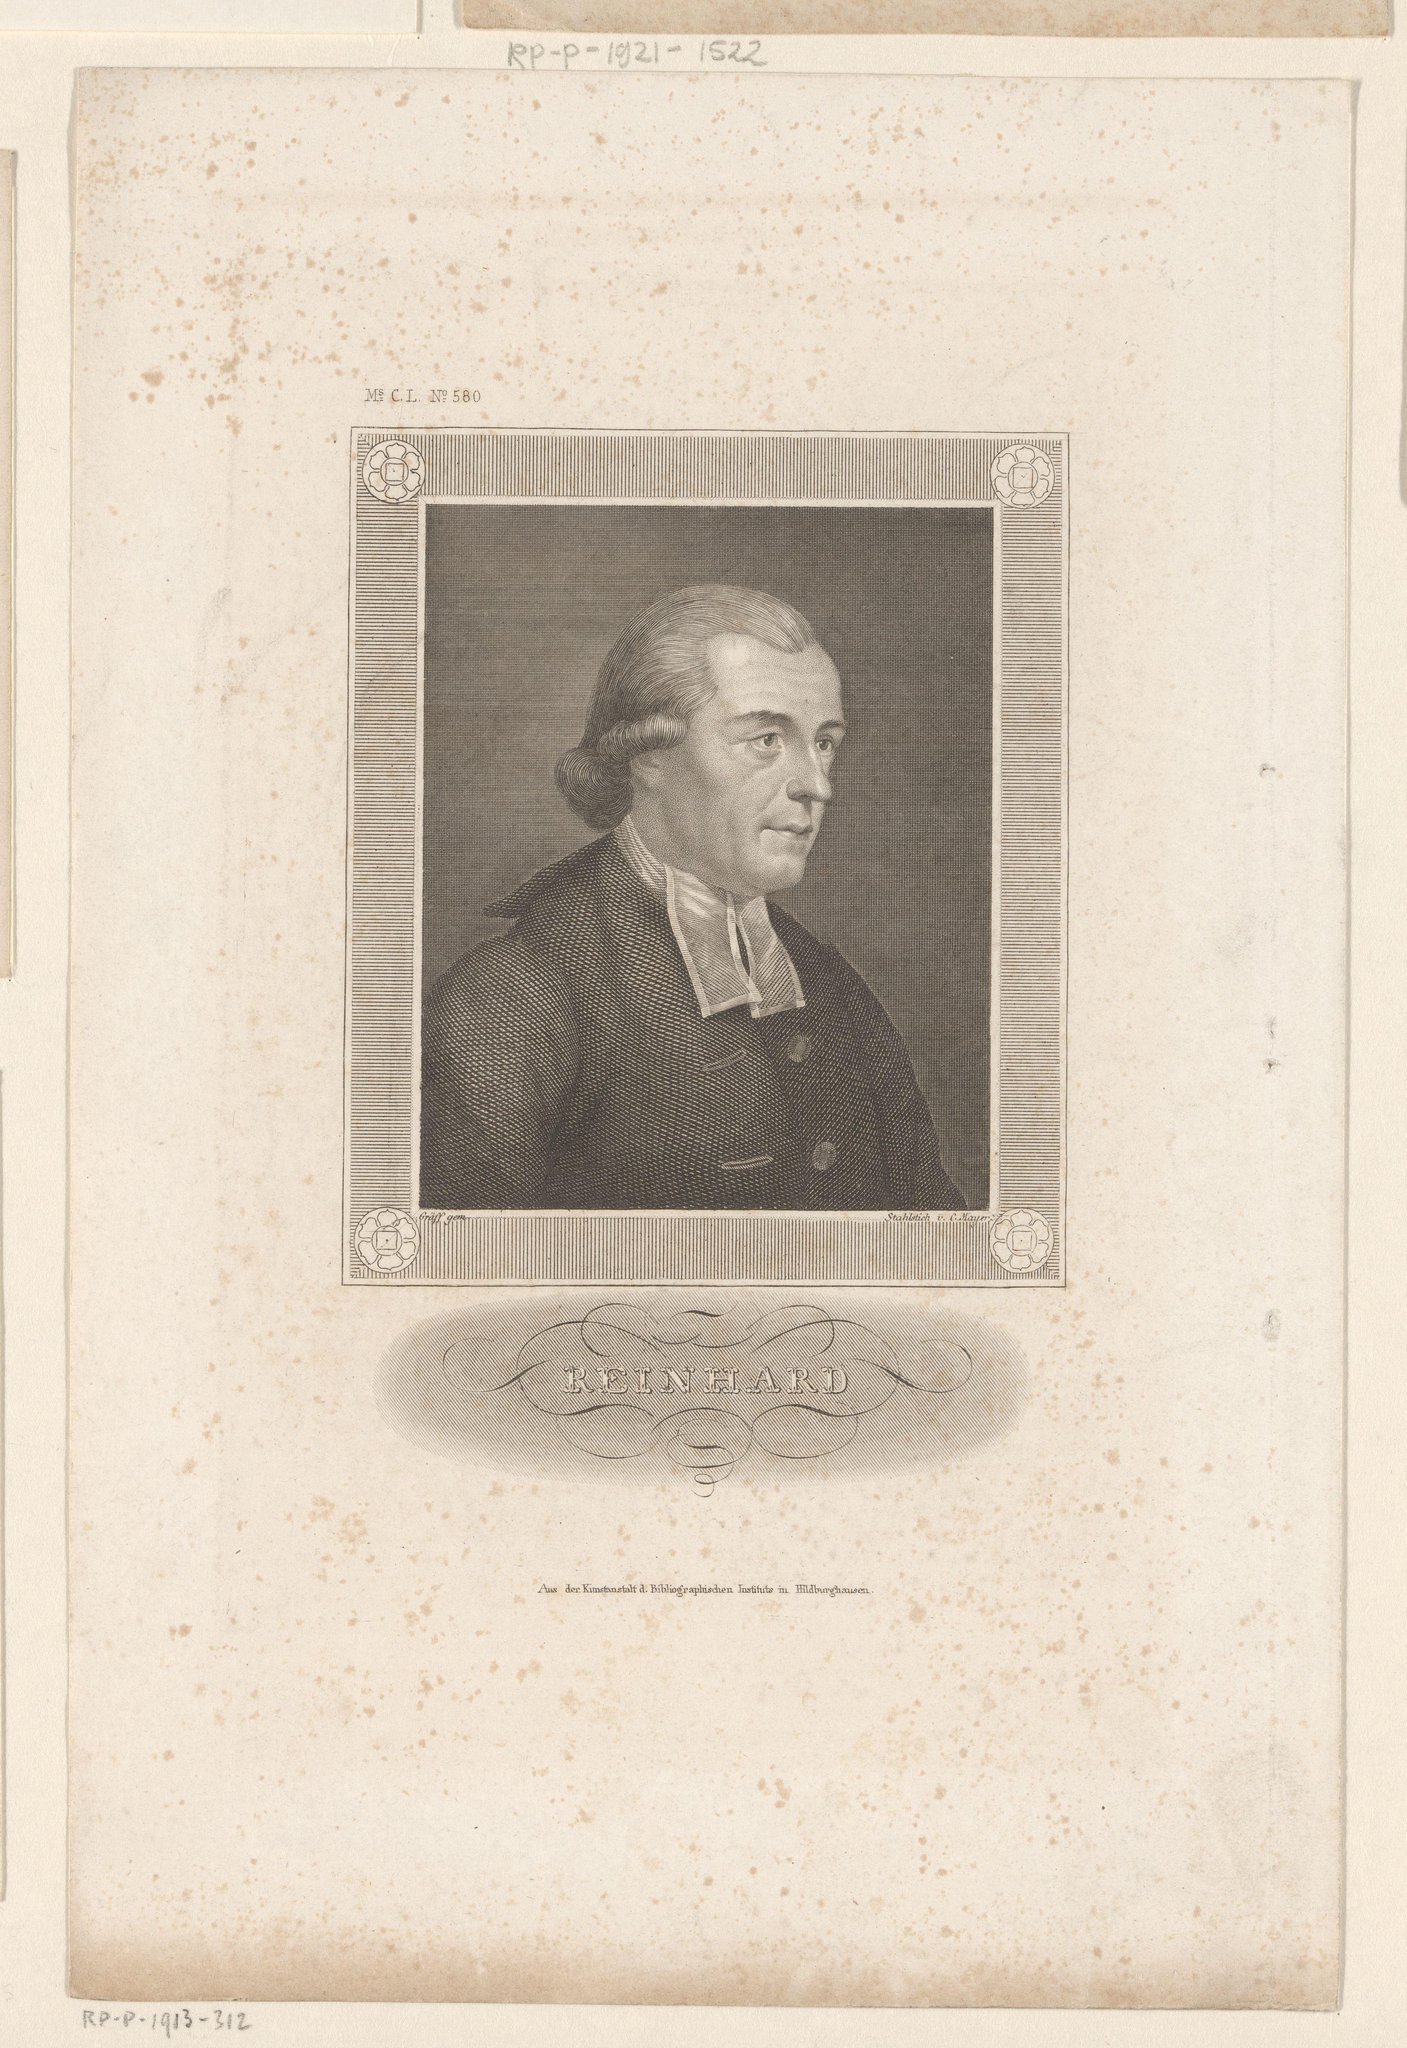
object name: print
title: Portret van Franz Volkmar Reinhard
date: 1840-1855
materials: paper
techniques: engraving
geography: hildburghausen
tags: theologian, further education (+ portrait of teacher, professor), historical persons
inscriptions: collector's mark: Lugt 2228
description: Prent uit: Meyer, Joseph. Das Grosse Conversations-Lexikon für die gebildeten Stände. Hildburghausen: Bibliographisches Institut, [1840-1855].